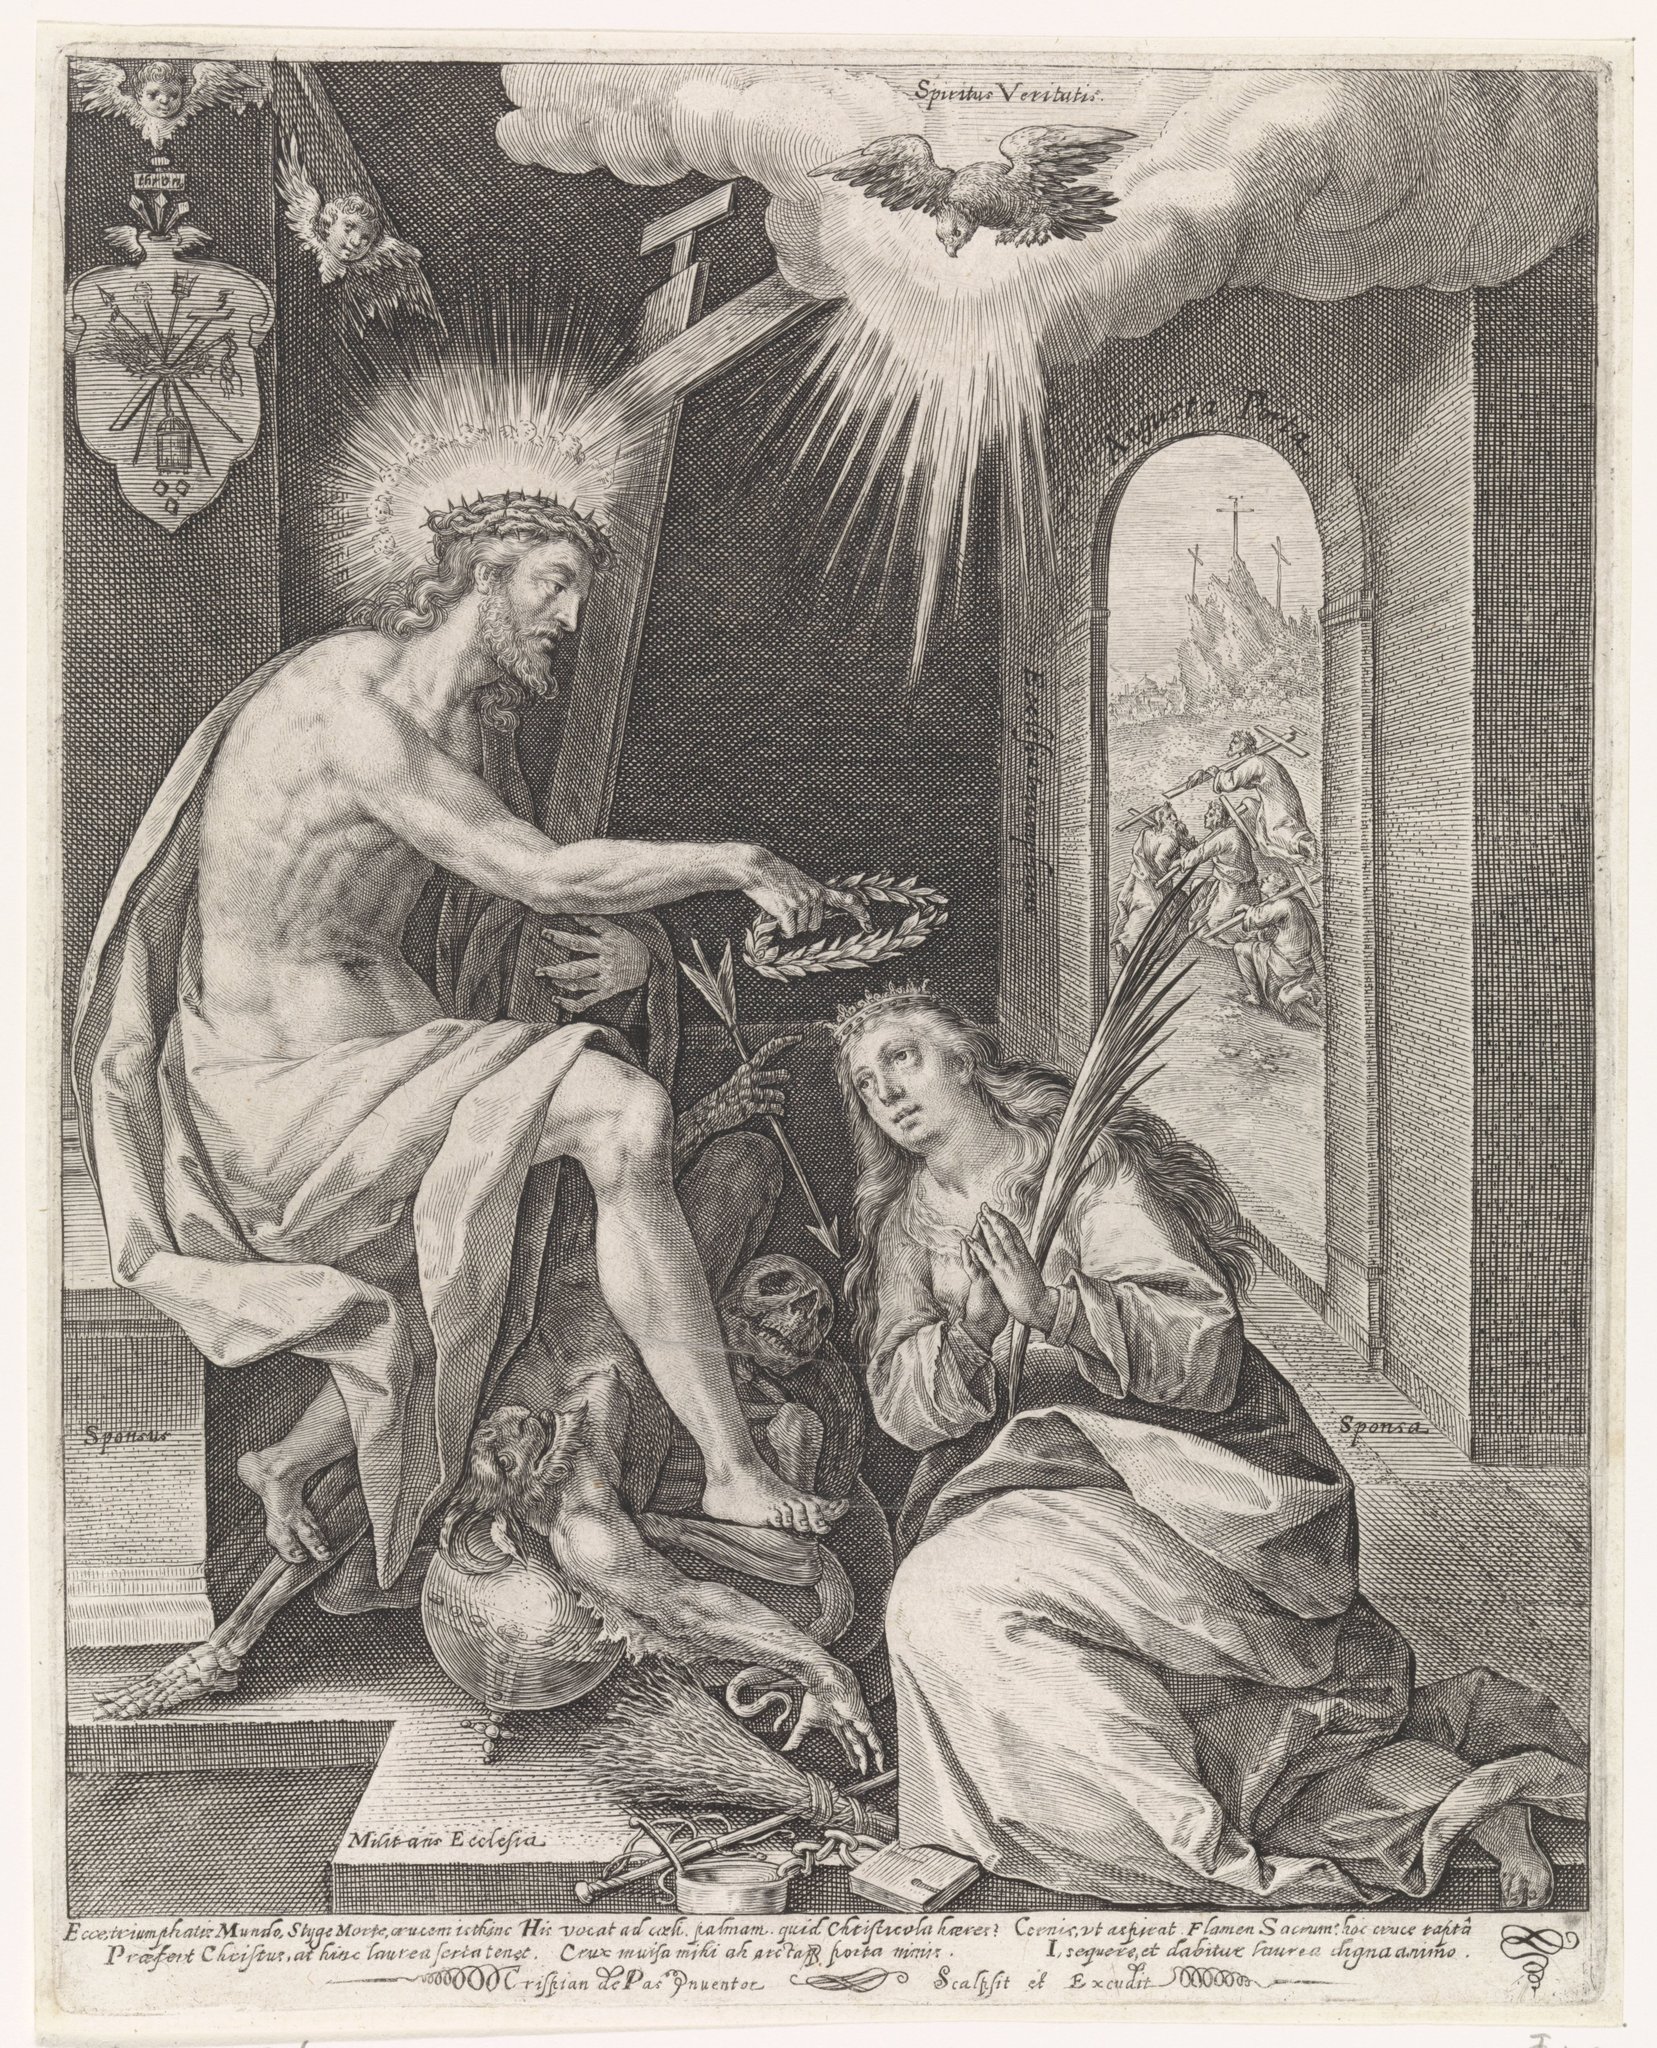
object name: print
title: Triomf van de kerk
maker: crispijn van de passe (i)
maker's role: draughtsman, print maker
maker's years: 1564-1637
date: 1574-1637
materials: paper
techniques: engraving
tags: devils in purely fantasy shape, death as skeleton, allegorical and symbolical representations ~ the church and religion, carrying of the cross: christ bearing the cross, alone or with the help of others (e.g. simon the cyrenian), holy ghost represented as a dove (in flames)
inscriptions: collector's mark: Lugt 2542, collector's mark: Lugt 2228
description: Allegorische voorstelling met Christus als bruidegom (Sponsus) die zijn bruid (Sponsa) kroont die voor hem knielt. De vrouw houdt een palmtak in haar handen. Christus zit op een troon en vertrapt de Dood die als skelet is voorgesteld en de duivel. Boven het bruidspaar verschijnt de Heilige Geest in de vorm van een duif. Door een deuropening is de kruisdraging van Christus en de misdadigers en de berg Golgota met de drie kruizen te zien. Linksboven een wapenschild met de passiewerktuigen. In de marge een zesregelig onderschrift, in drie kolommen, in het Latijn.